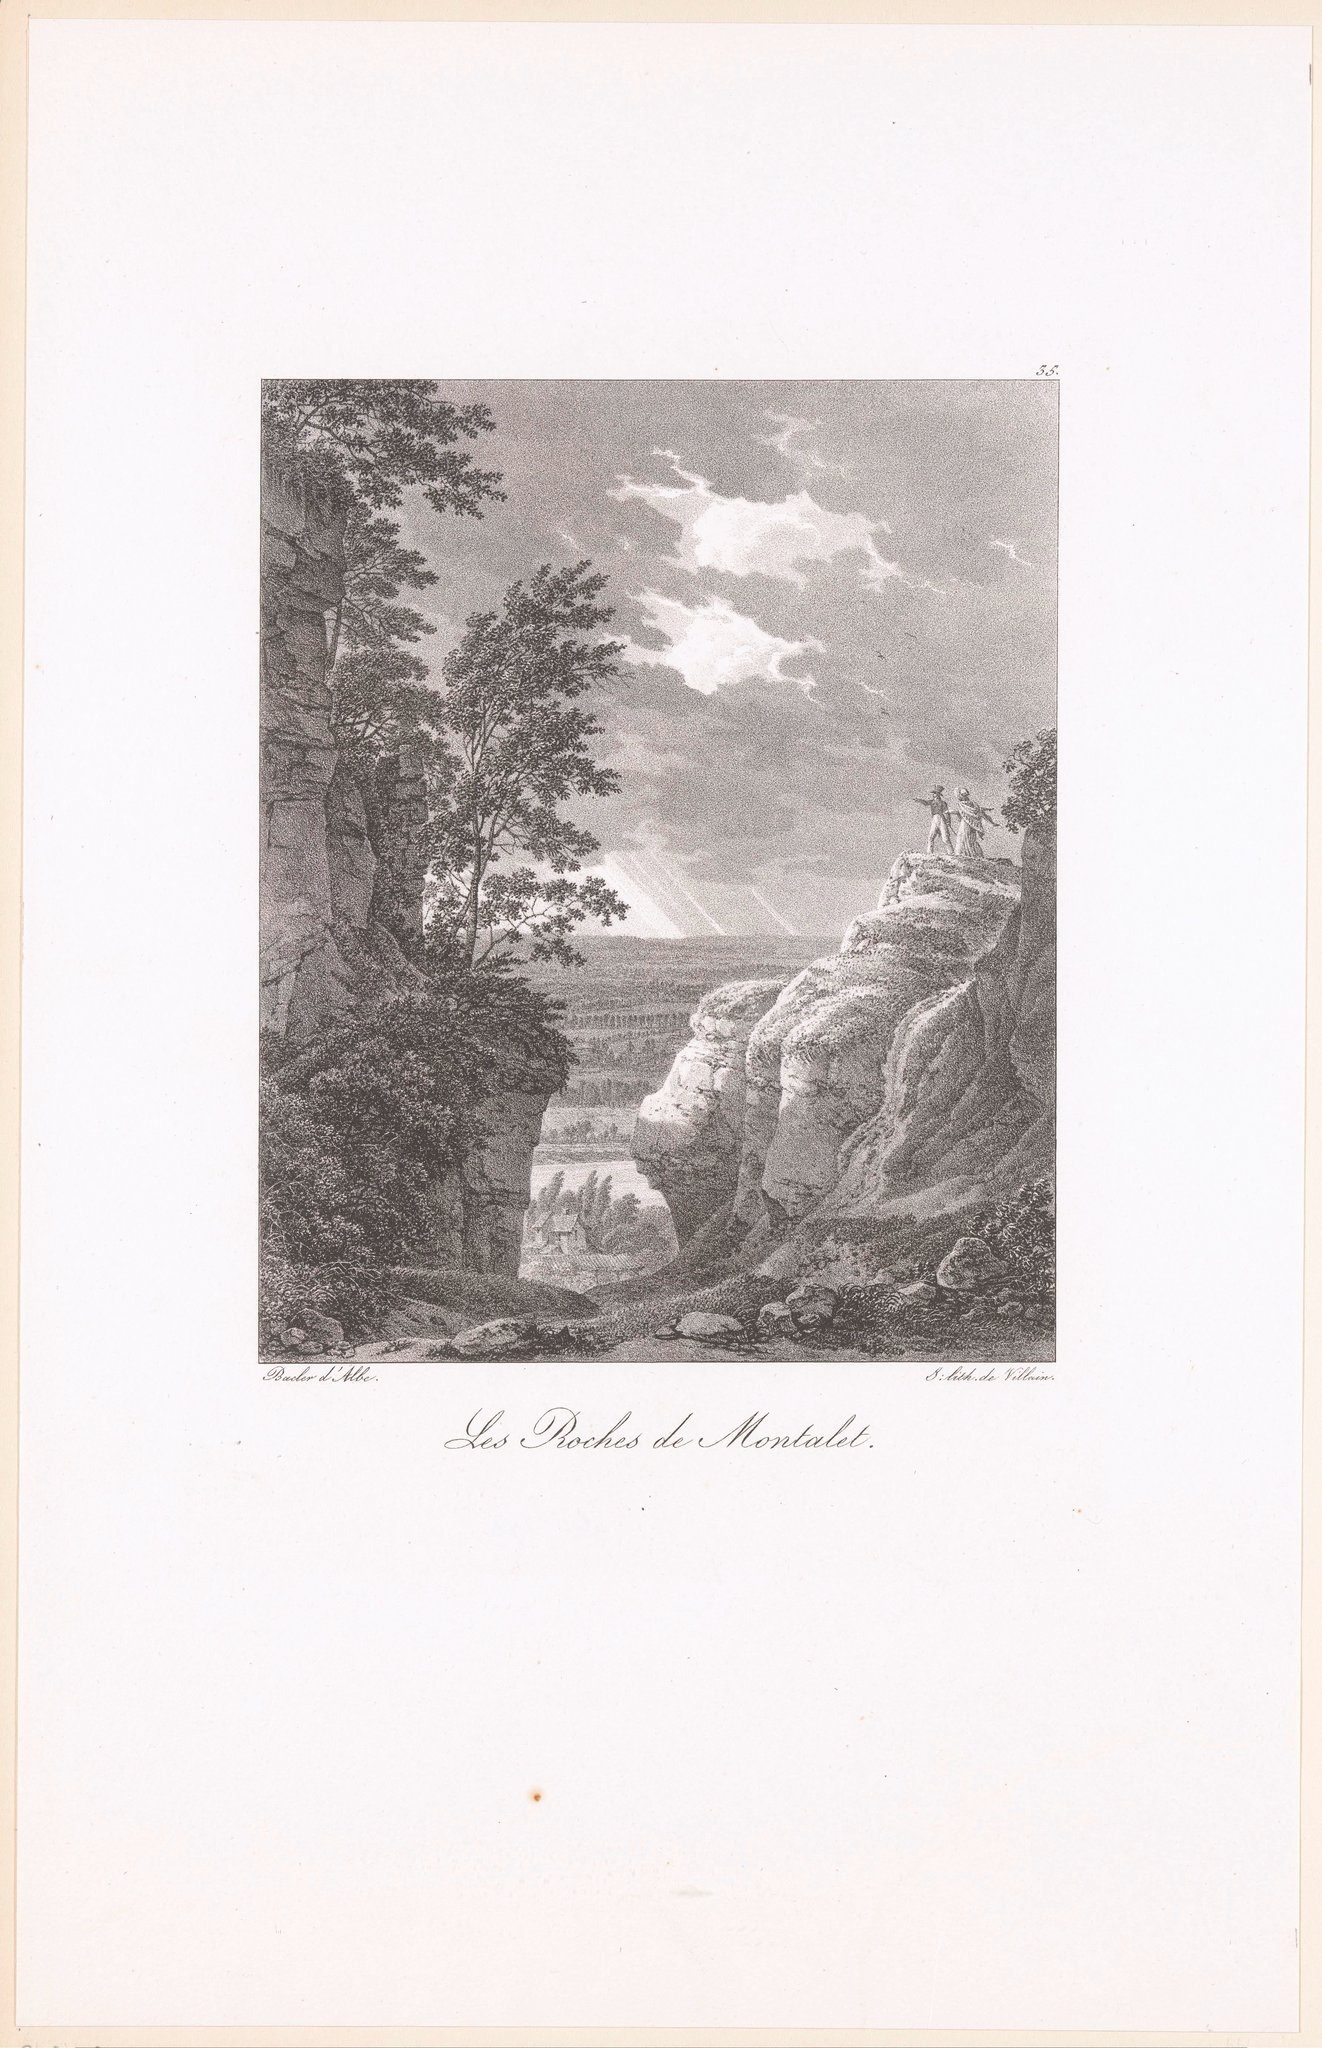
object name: print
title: Les roches de Montalet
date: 1822-1824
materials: paper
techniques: lithograph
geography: paris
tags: ravine, chasm, abyss, canyon, rock-formations, farm or solitary house in landscape